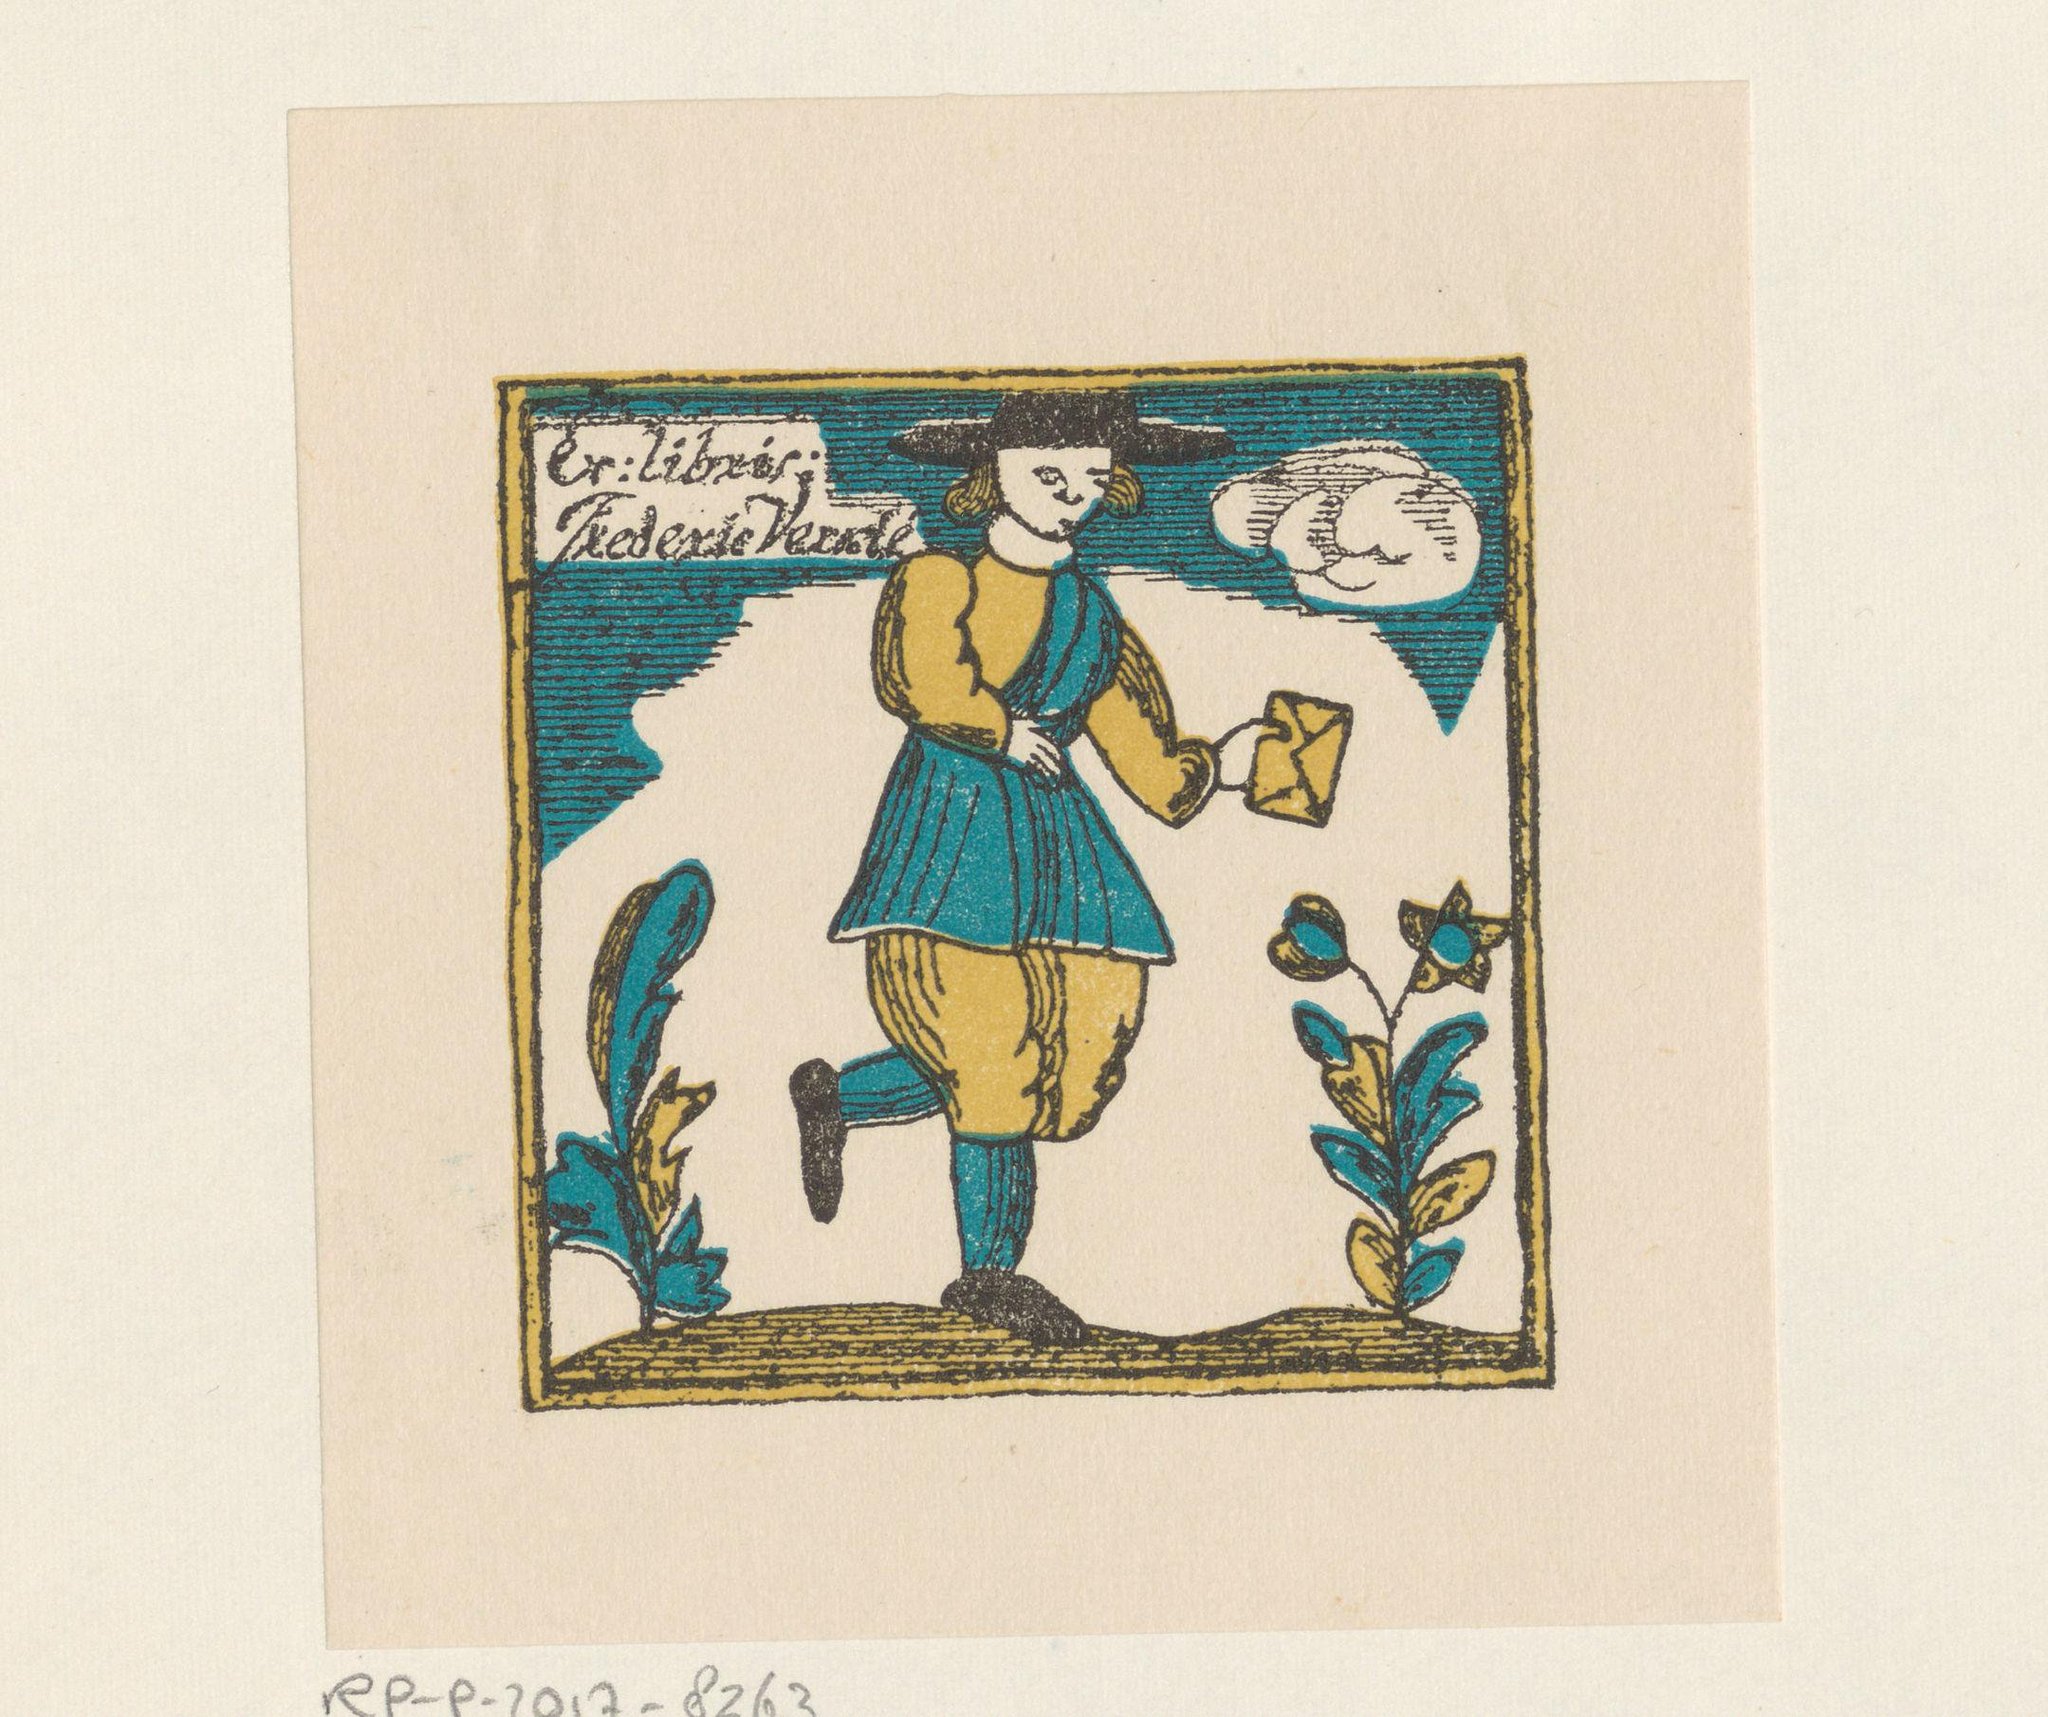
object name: bookplate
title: Ex libris van Frederic Ve[...]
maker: Anonymous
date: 1900-1949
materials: paper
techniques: printing block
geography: spain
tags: messenger, letter, envelope